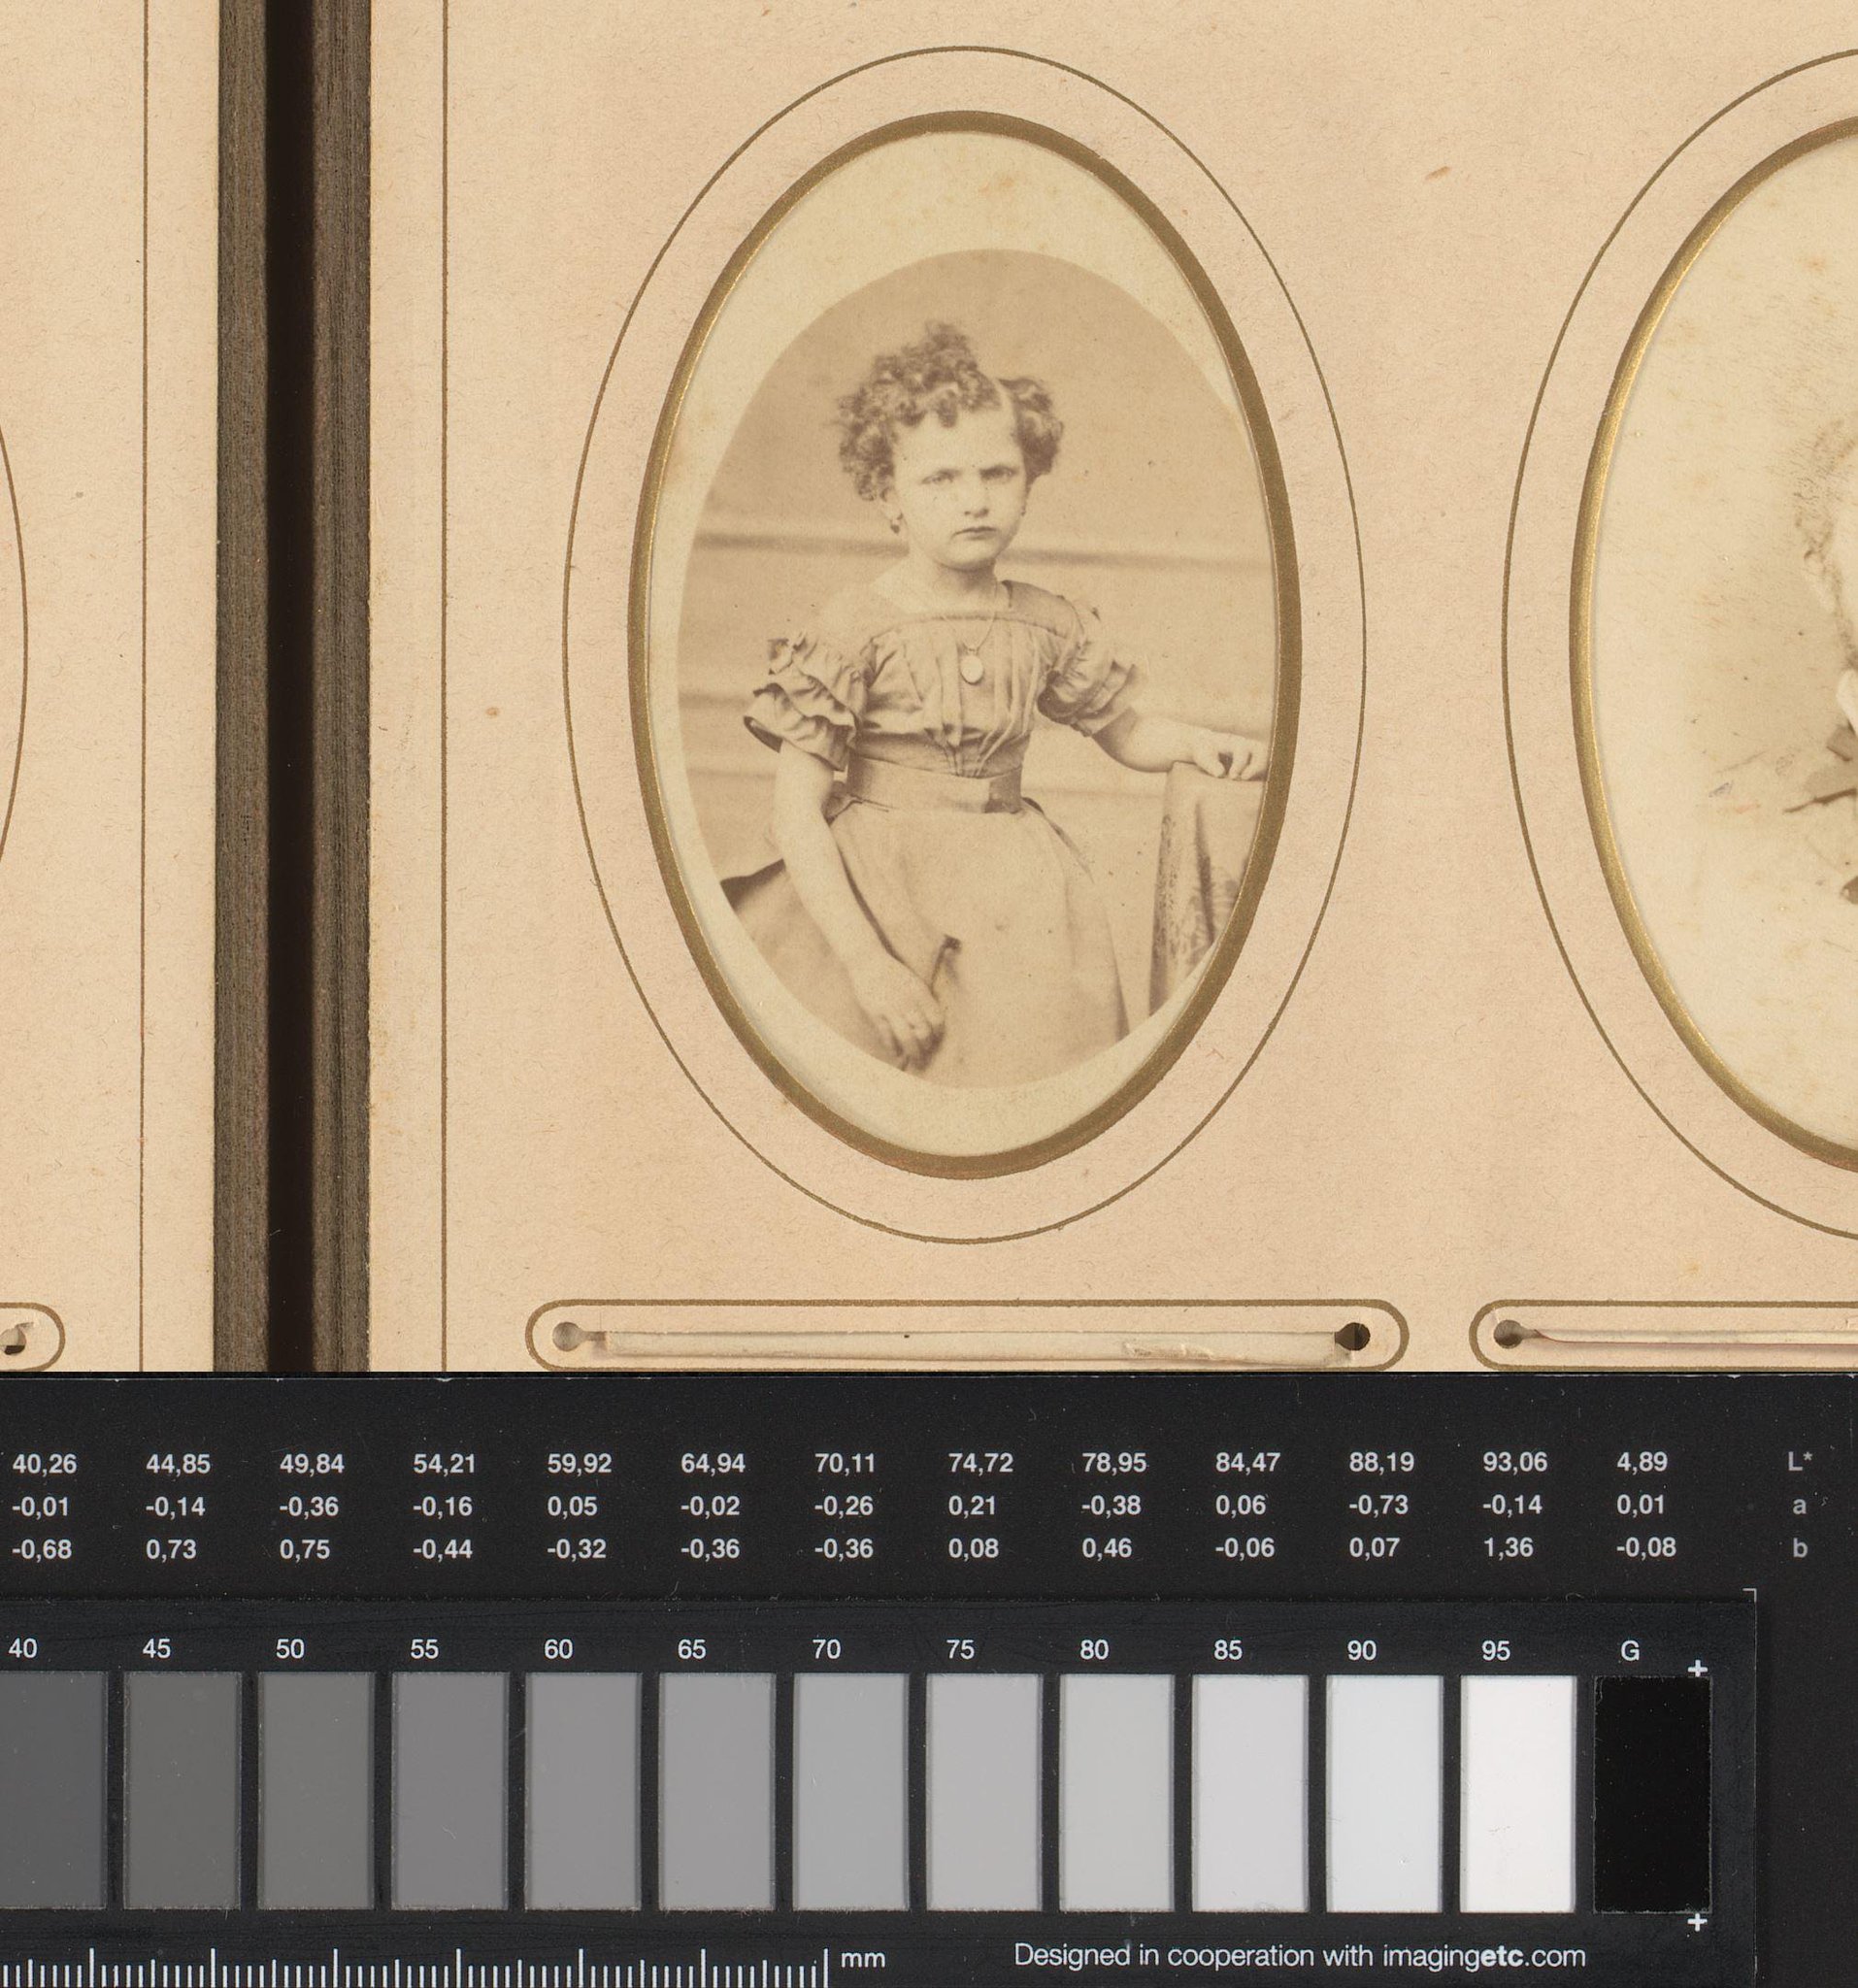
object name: photograph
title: Portret van een onbekend meisje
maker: j.b.a. van loo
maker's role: fotograaf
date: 1880-1890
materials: cardboard, paper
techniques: albumen print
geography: rotterdam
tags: anonymous historical person portrayed - bb - woman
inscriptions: address: ‘BINNEHOF/ KRUISKADE/ ROTTERDAM’